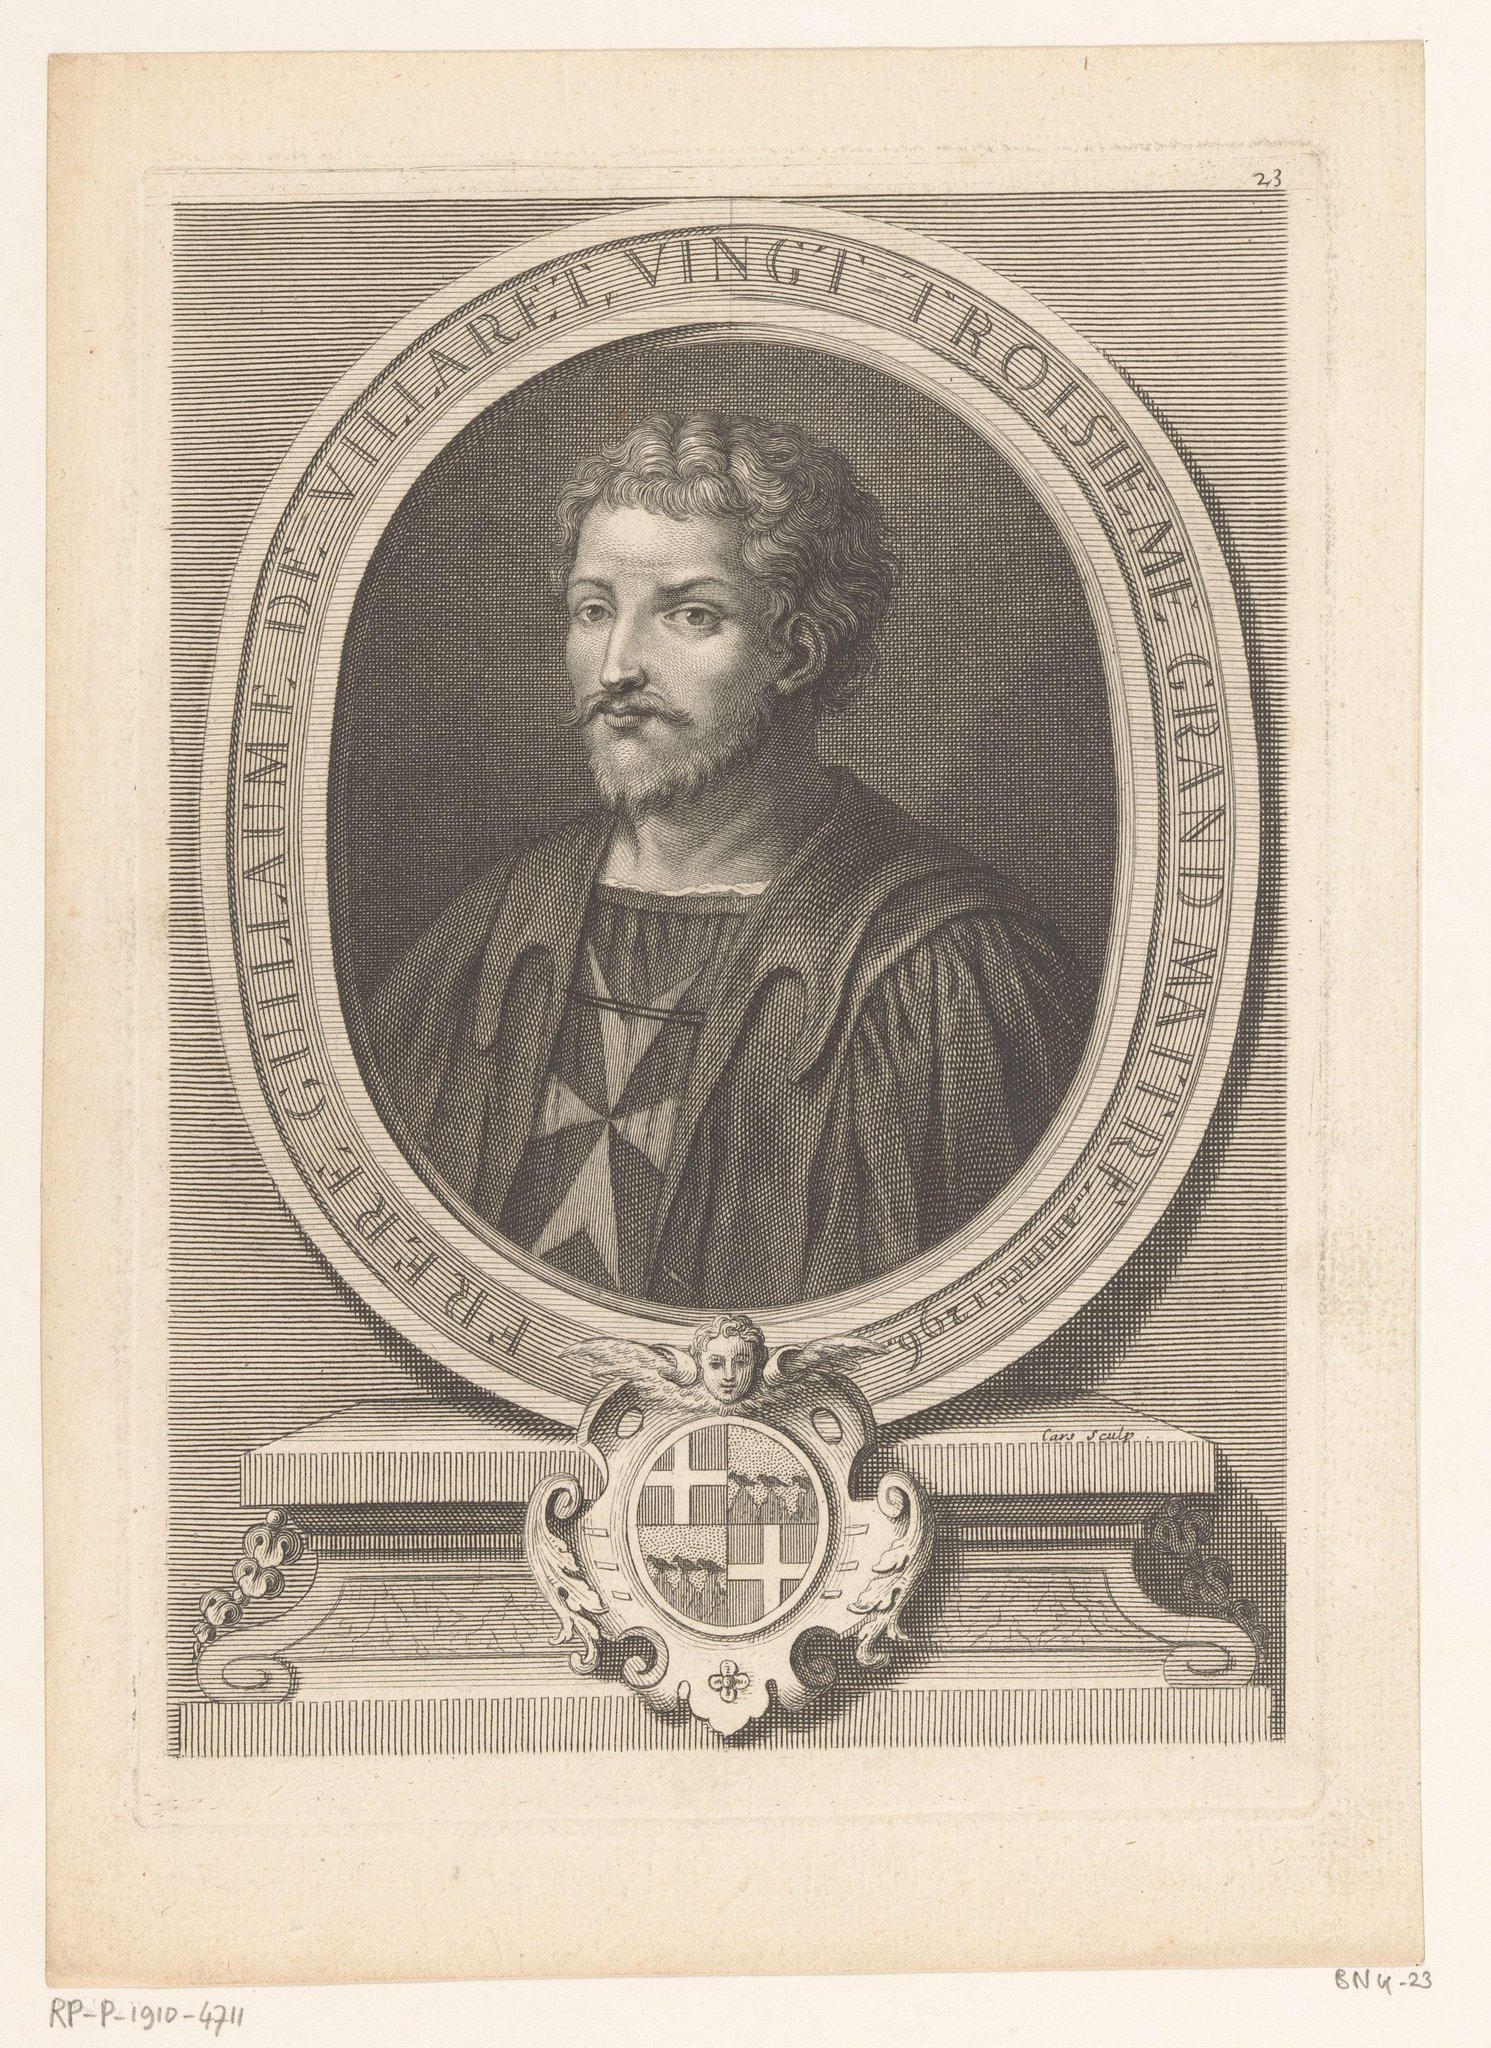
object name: print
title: Portret van Guillaume de Villaret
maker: laurent cars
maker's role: print maker, publisher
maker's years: 1699-1771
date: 1726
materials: paper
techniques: engraving, etching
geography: france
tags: historical persons, military orders, e.g.: knights templars, knights of malta, teutonic knights ~ roman catholic church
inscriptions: collector's mark: Lugt 2228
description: Prent uit: Vertot, René Aubert de. Histoire des Chevaliers hospitaliers de St Jean de Jérusalem. Parijs: Rollin, Quillau, Desaint, 1726. Illustratie op p. 451 van deel 1. Cars vervaardigde portretten van 65 grootmeesters van de Maltezer Orde.